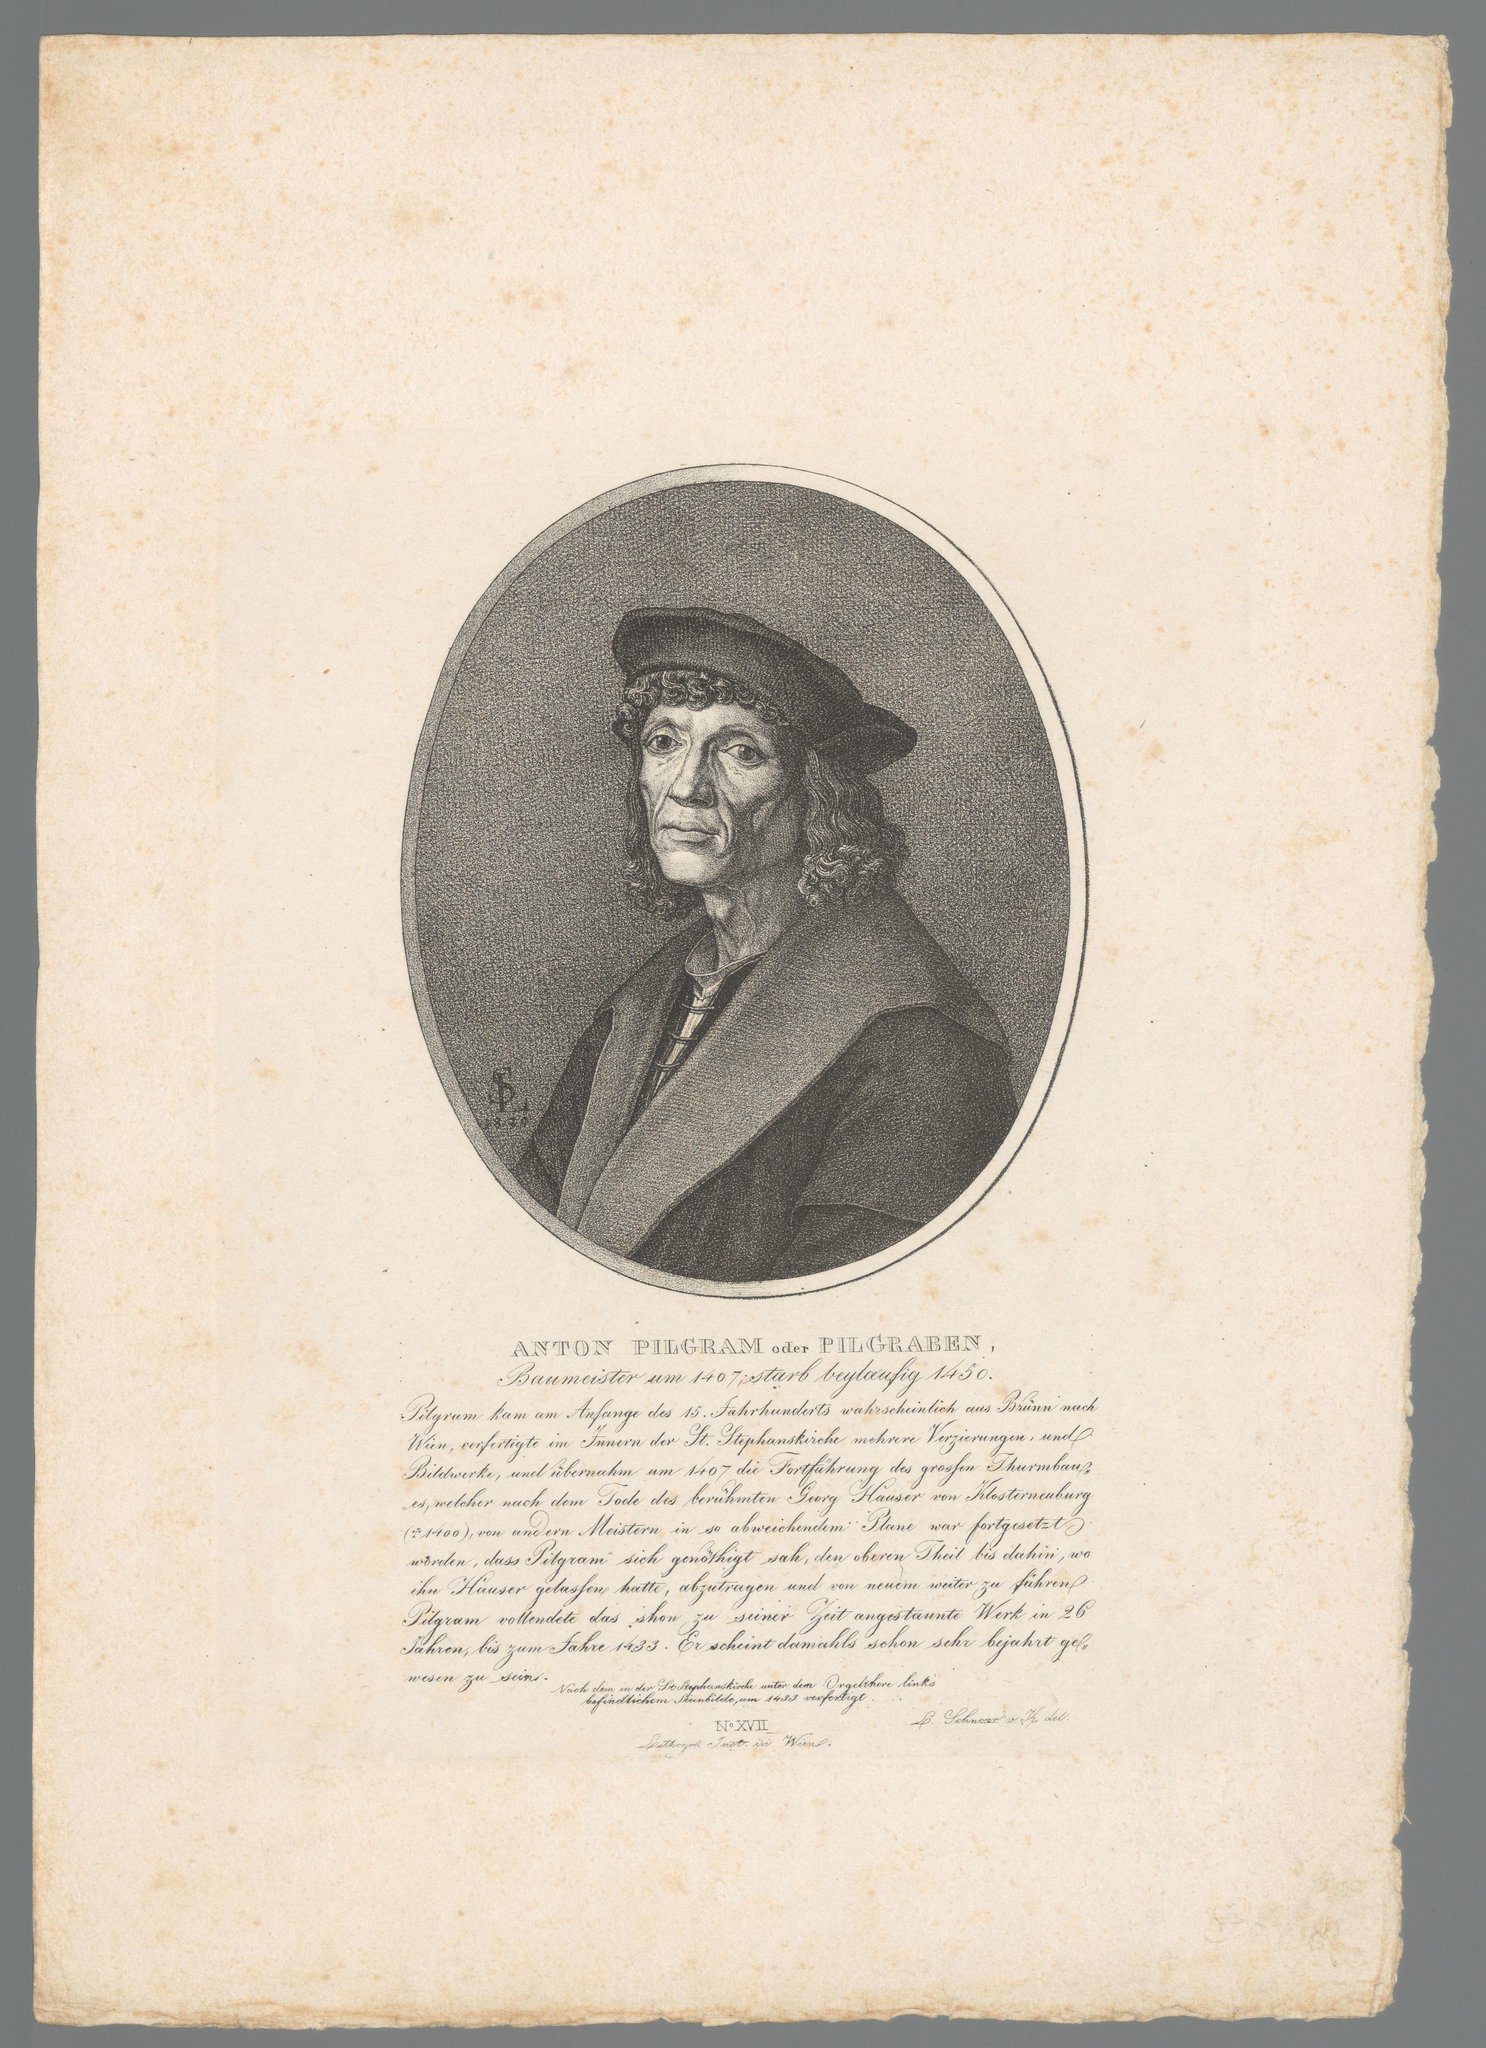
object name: print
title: Portret van Anton Pilgram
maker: ludwig ferdinand schnorr von carolsfeld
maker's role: print maker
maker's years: 1788-1853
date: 1820-1853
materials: paper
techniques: lithograph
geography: vienna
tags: astronomy (and cosmography) (+ portrait of scholar, scientist), historical persons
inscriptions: collector's mark: Lugt 2228